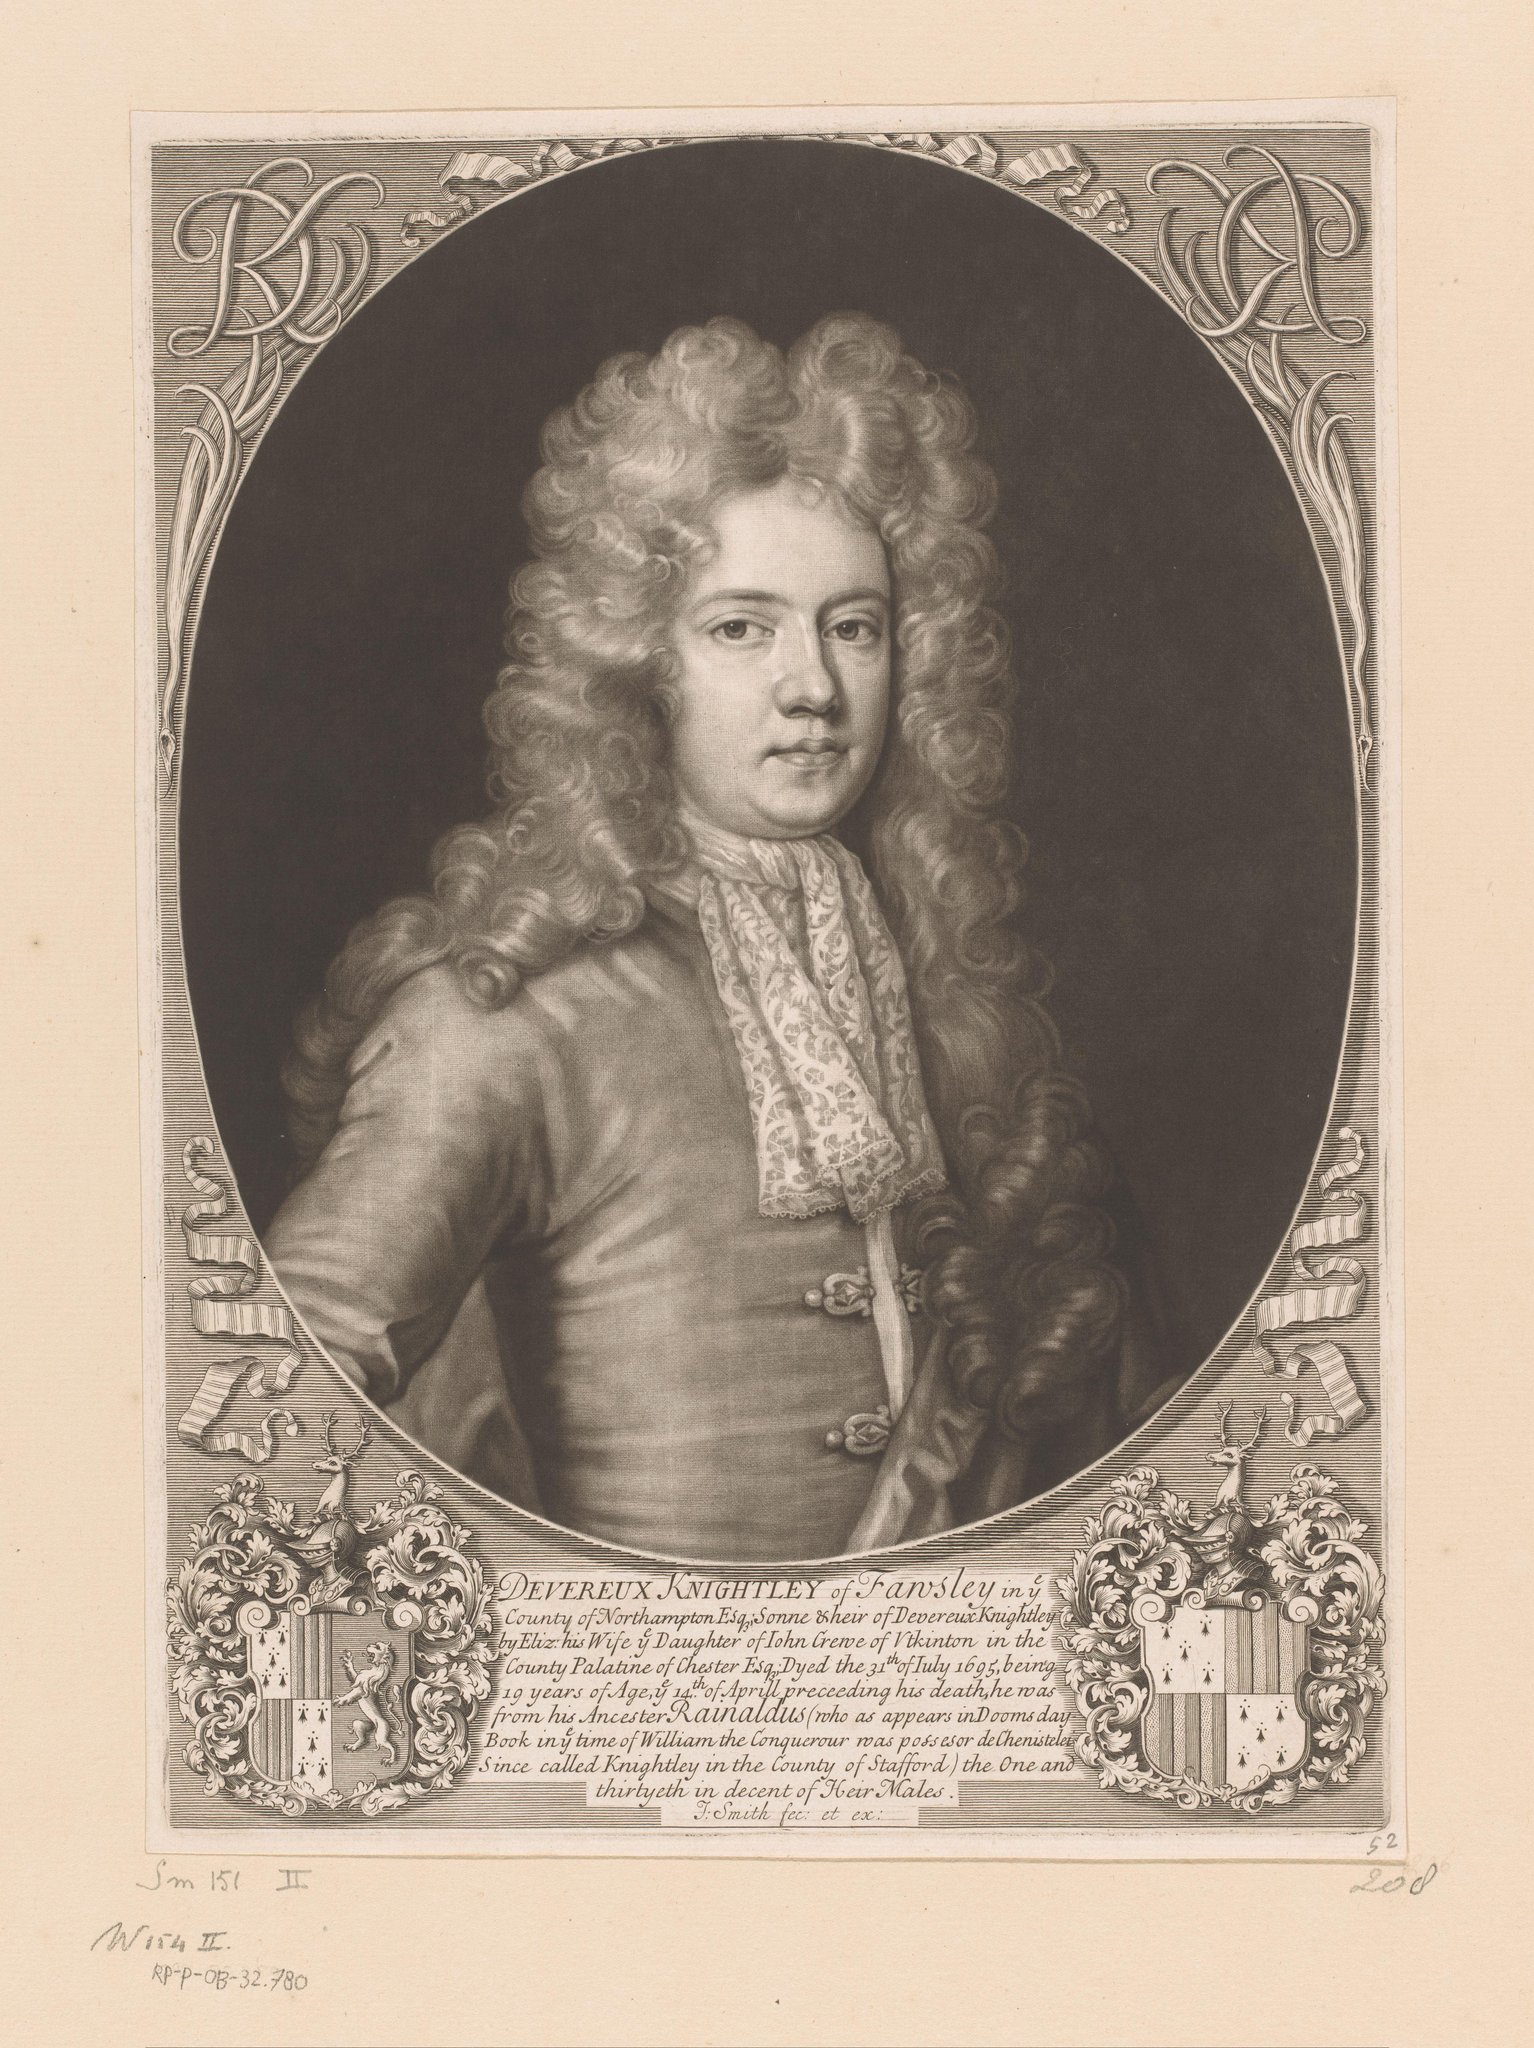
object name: print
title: Portret van Devereux Knightley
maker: john smith (prentmaker/ uitgever)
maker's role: print maker, publisher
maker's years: 1652-1743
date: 1695-1742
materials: paper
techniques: engraving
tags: historical persons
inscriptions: collector's mark: Lugt 240